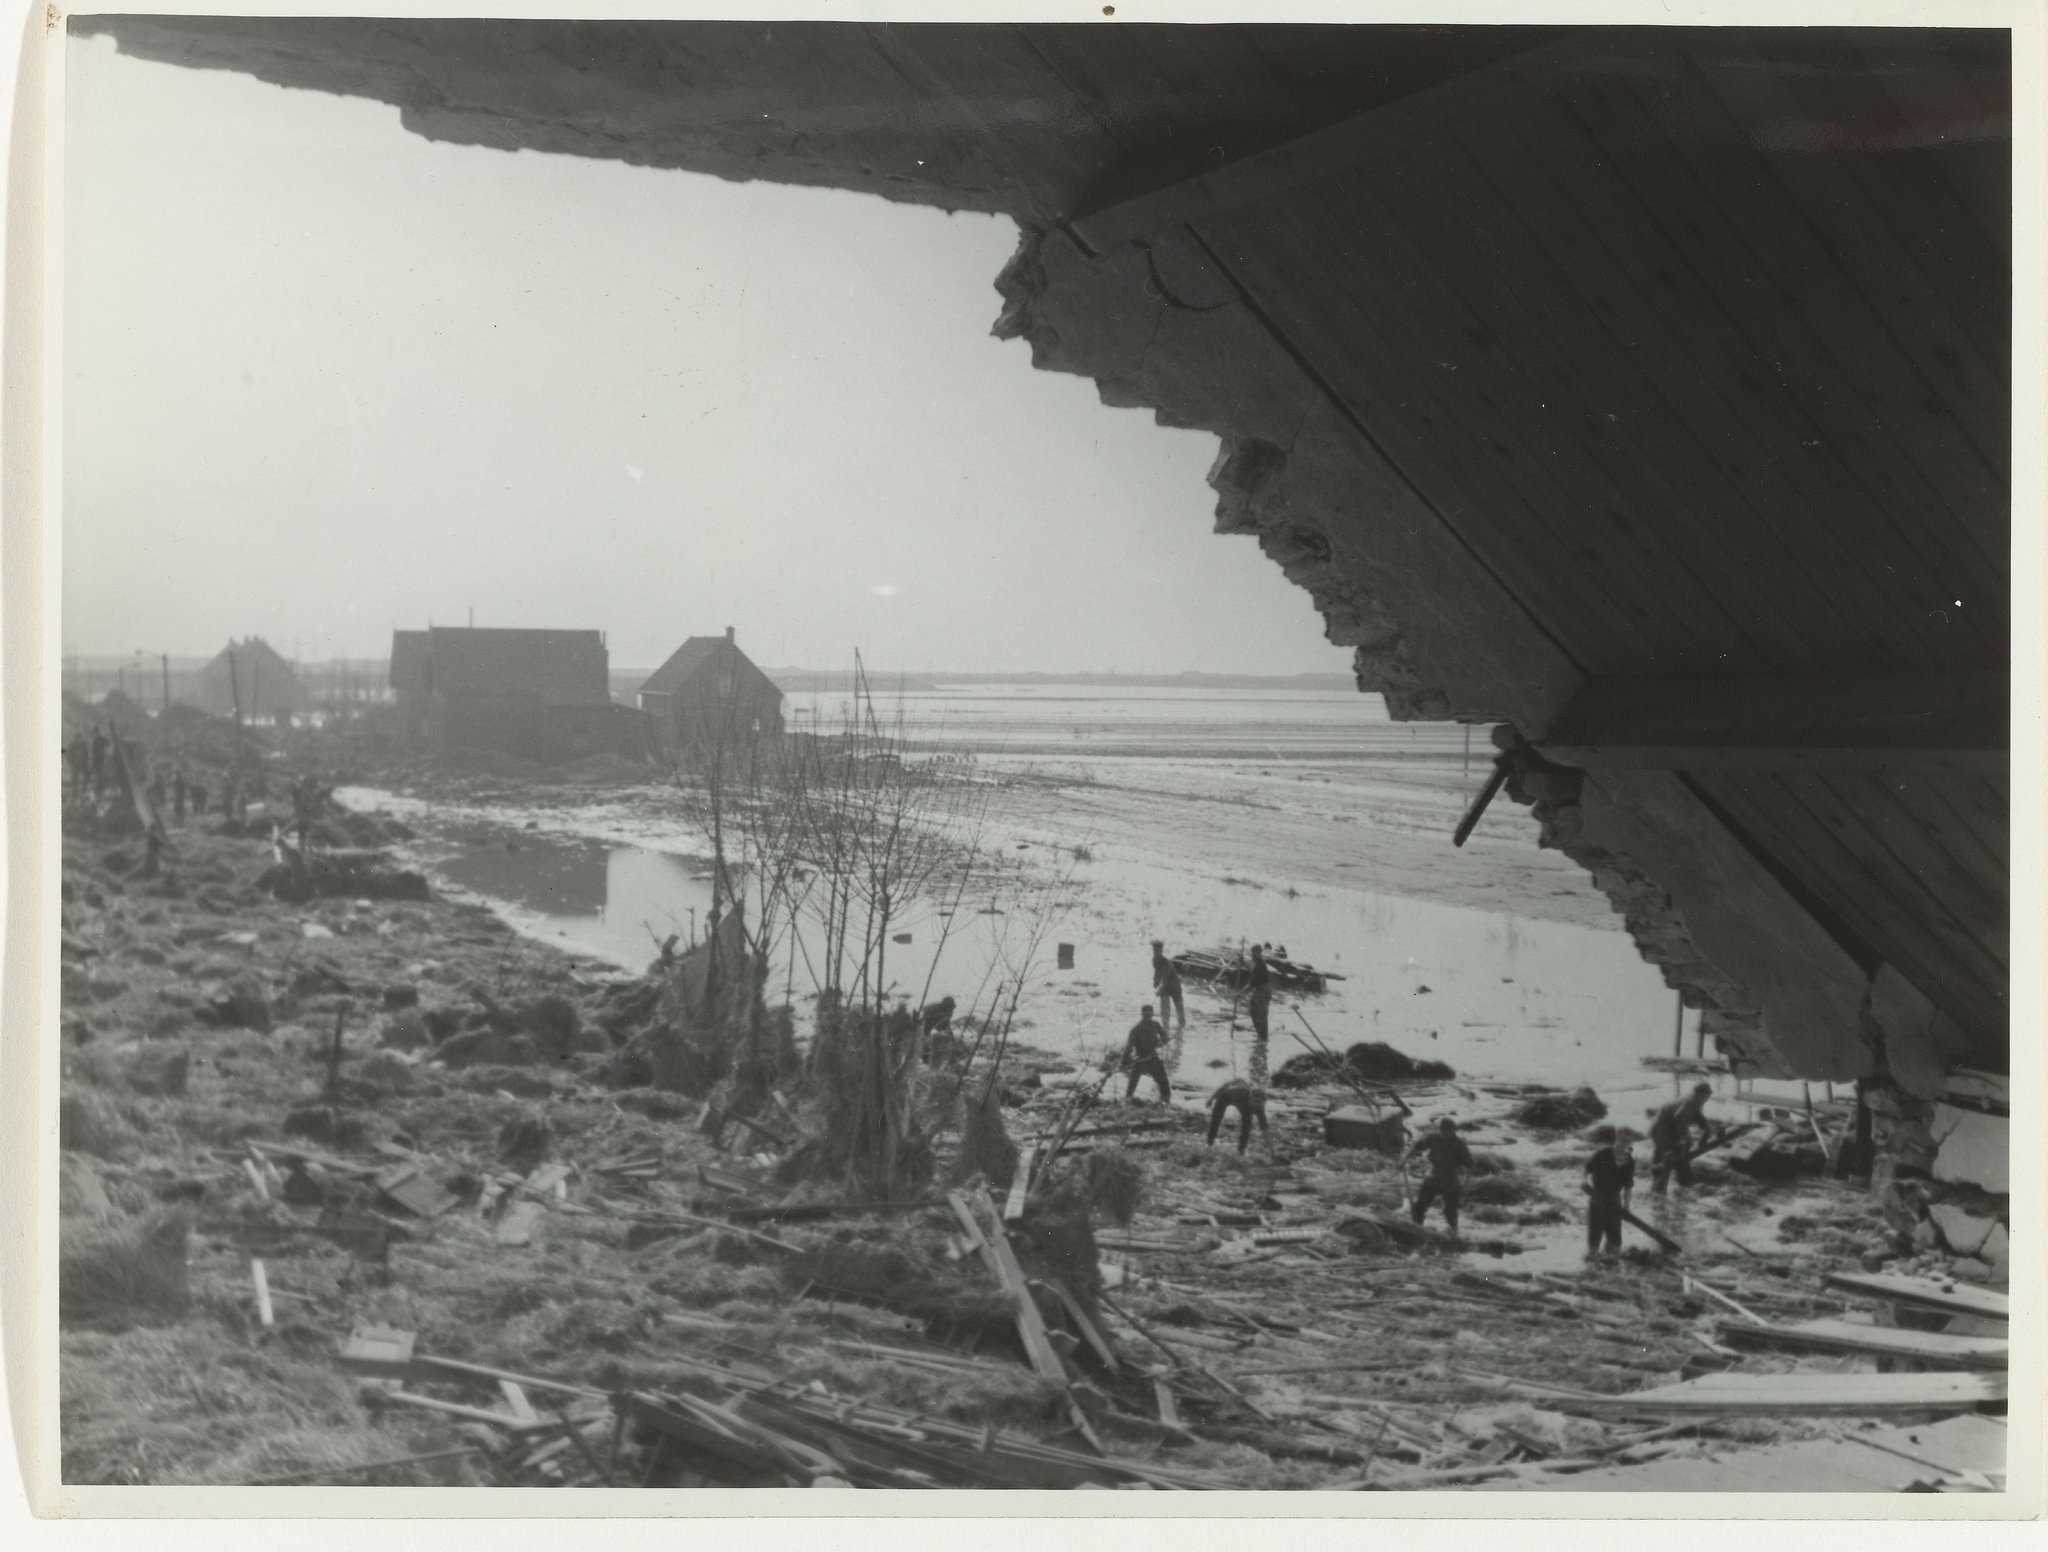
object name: photograph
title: Watersnoodramp 1953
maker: Anonymous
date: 1953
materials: photographic support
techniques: photography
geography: zeeland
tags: zeeland, north sea flood of 1953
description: Onder een ingestorte brug zijn mannen bezig puin te ruimen. Op de achtergrond een boerderij en deels nog ondergelopen land.